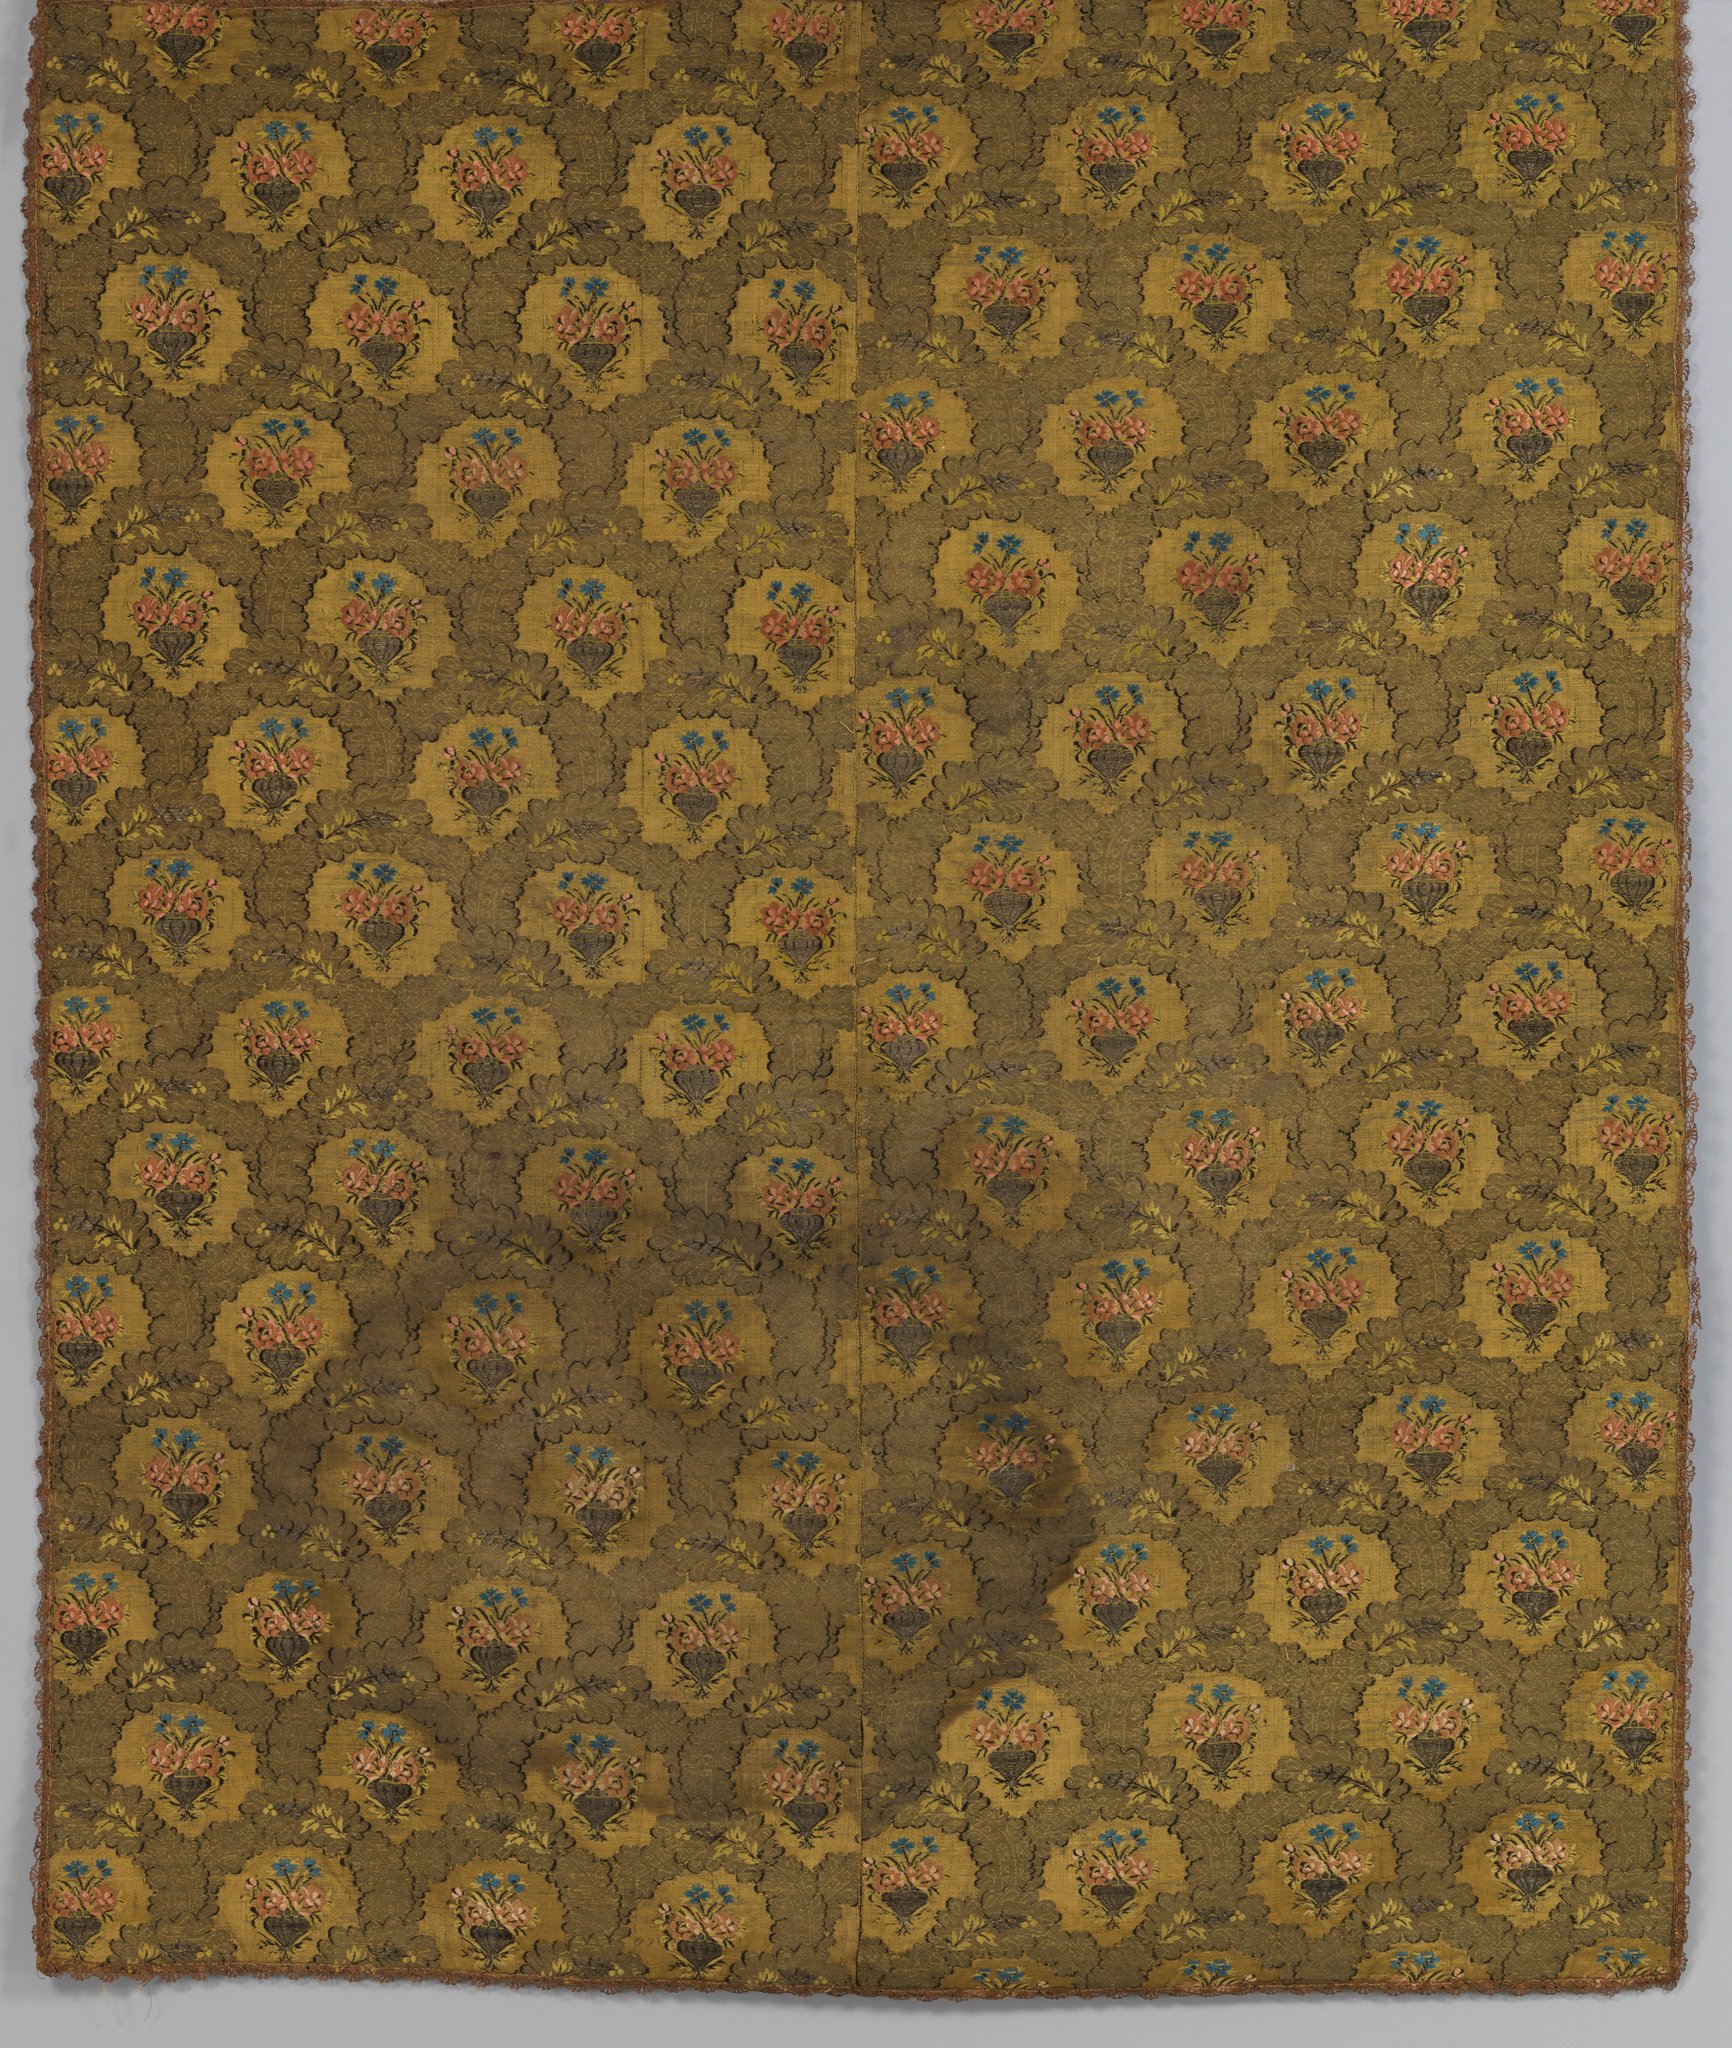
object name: piece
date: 1751-1800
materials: metal thread, silk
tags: flowers